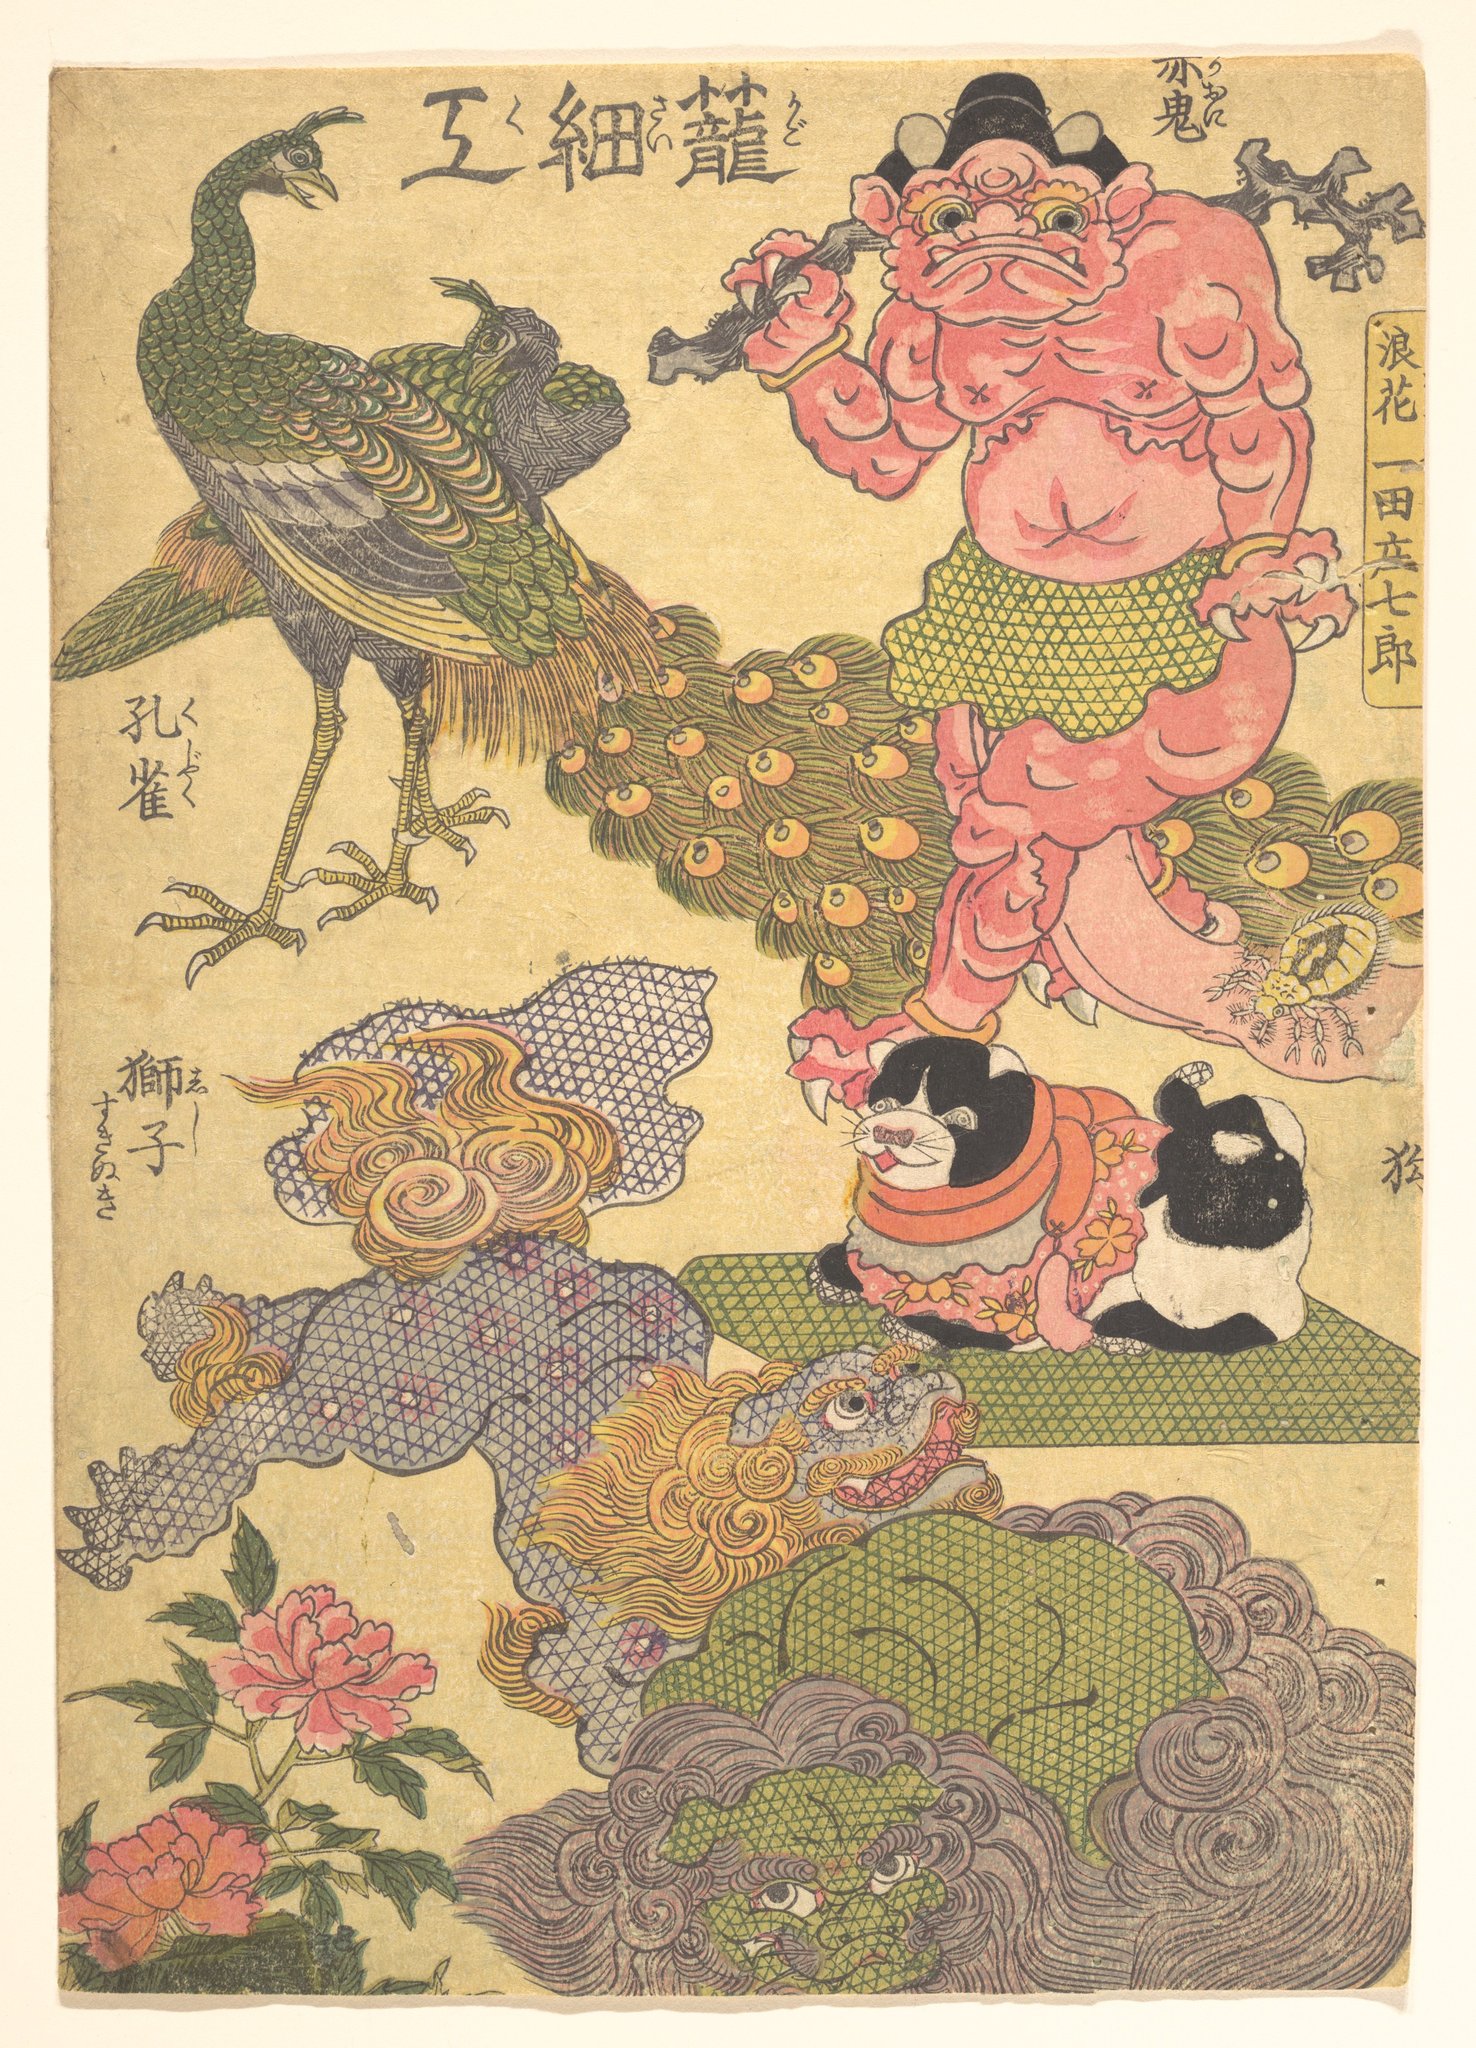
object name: print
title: Basketry Work: By the Craftsman Ichida Shōshichirō of Naniwa (Kagozaiku Naniwa saikunin Ichida Shōshichirō)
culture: japanese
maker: utagawa kunisada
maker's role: artist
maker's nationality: japanese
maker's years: 1786-1864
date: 1819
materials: ink, paper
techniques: woodblock print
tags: peacocks,cats,lions